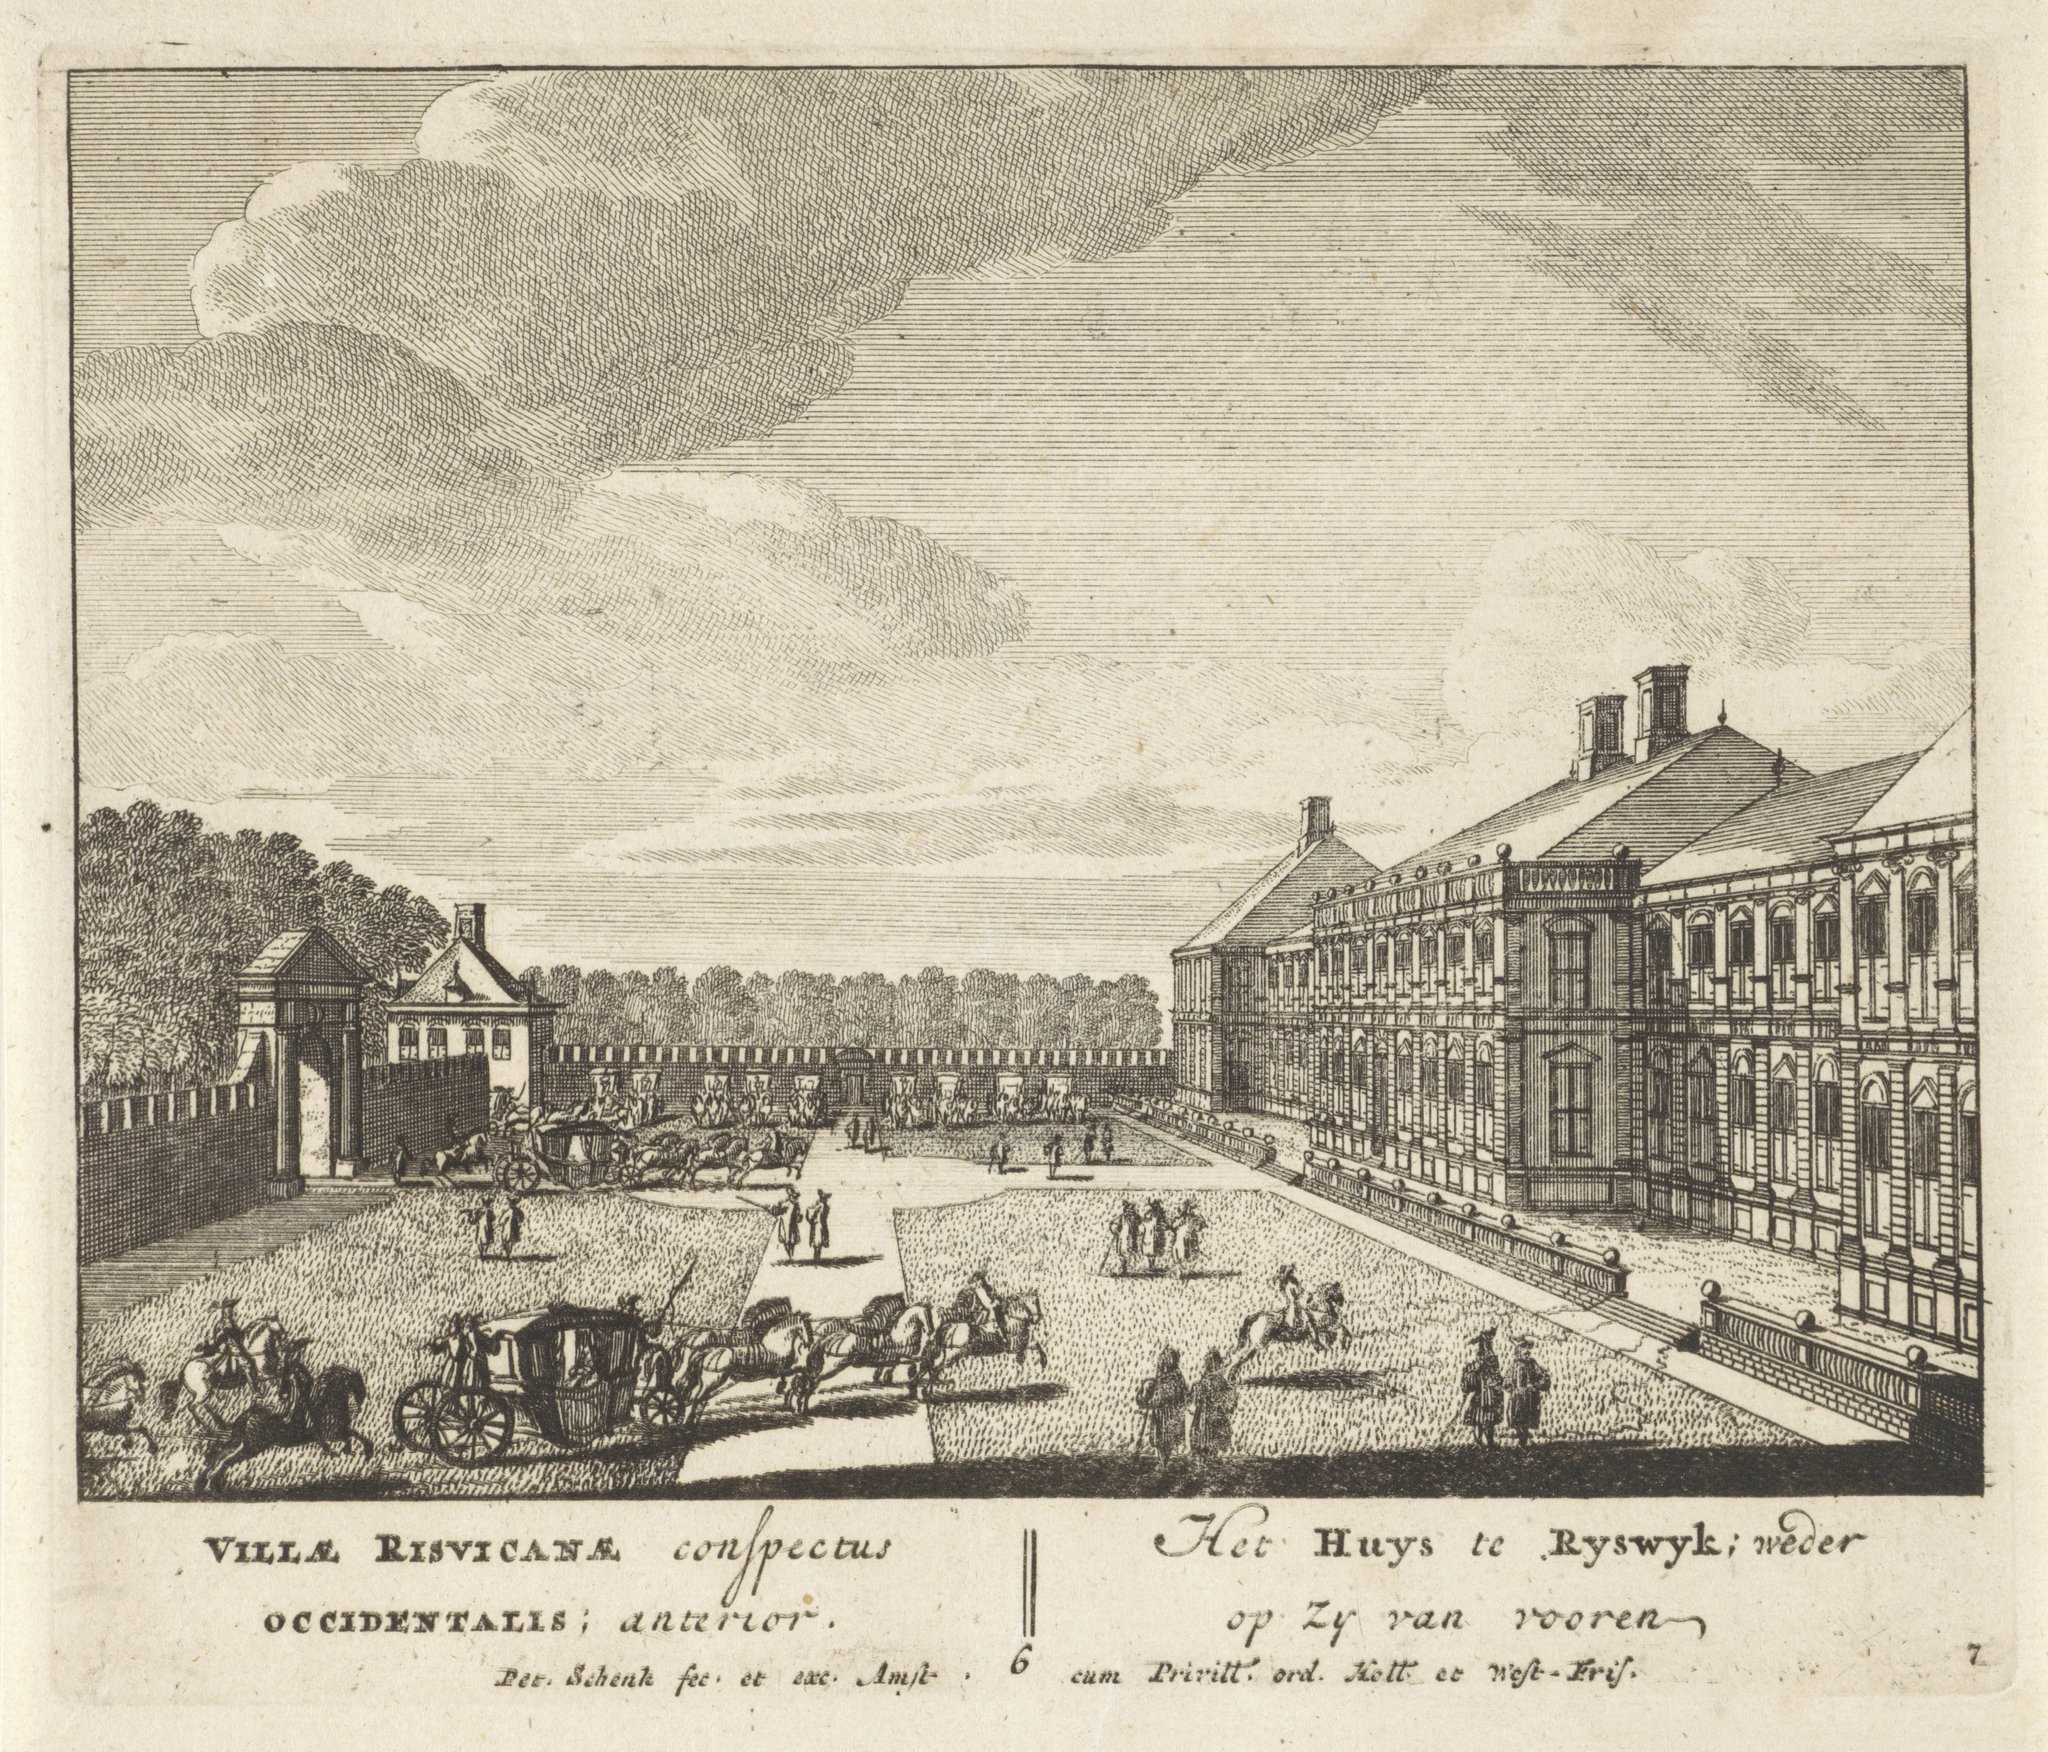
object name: print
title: Het Huys te Ryswyk weder op Zy van vooren / Villae Risvicanae conspectus occidentalis (...)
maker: pieter schenk (i)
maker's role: print maker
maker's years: 1660-1711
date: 1697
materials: paper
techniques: etching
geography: amsterdam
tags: palace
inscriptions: collector's mark: Lugt 2228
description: Gezicht op de zijkant en de voorkant van Huis ter Nieuburch te Rijswijk. In de ommuurde tuinen wandelaars en koetsen.